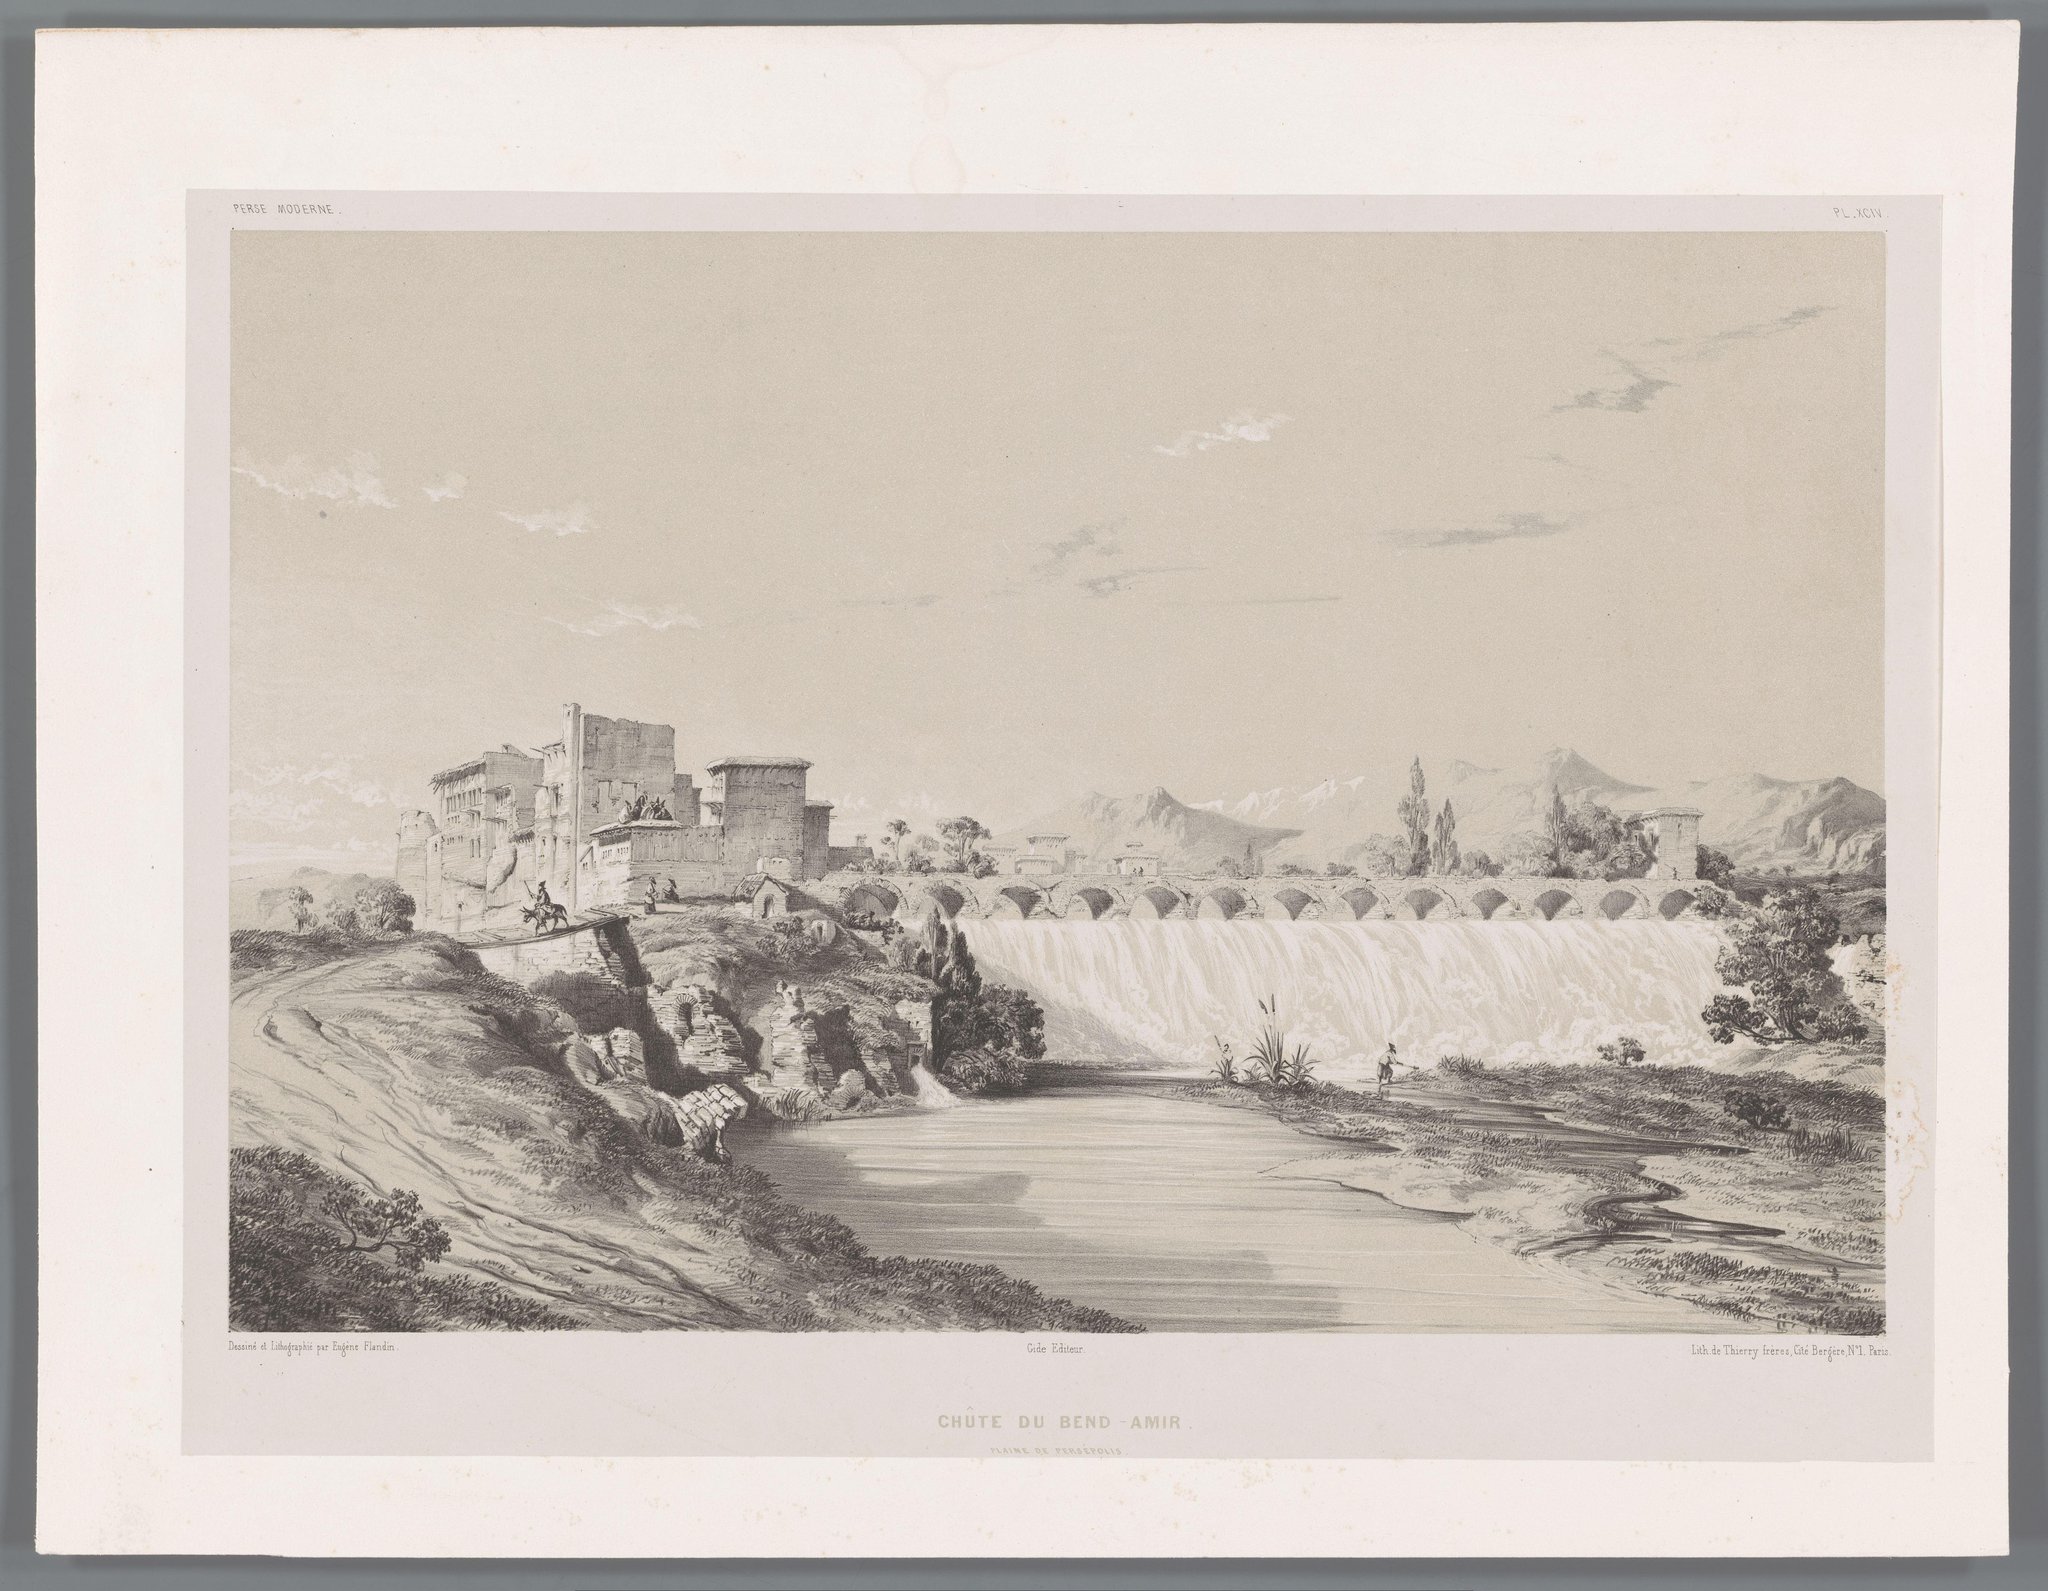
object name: print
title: Perzische landschappen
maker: eugène flandin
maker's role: painter, print maker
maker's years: 1809-1889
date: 1843-1854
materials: paper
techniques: tone lithography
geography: paris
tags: river (+ landscape with figures, staffage), waterfall (+ landscape with figures, staffage)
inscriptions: collector's mark: Lugt 2228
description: Links van de waterval een bouwwerk. Over de waterval loopt een brug, met daarachter nog enkele bouwwerken en een bergketen. Links boven de afbeelding de serietitel, rechtsboven het plaatnummer "Pl. XCIV".